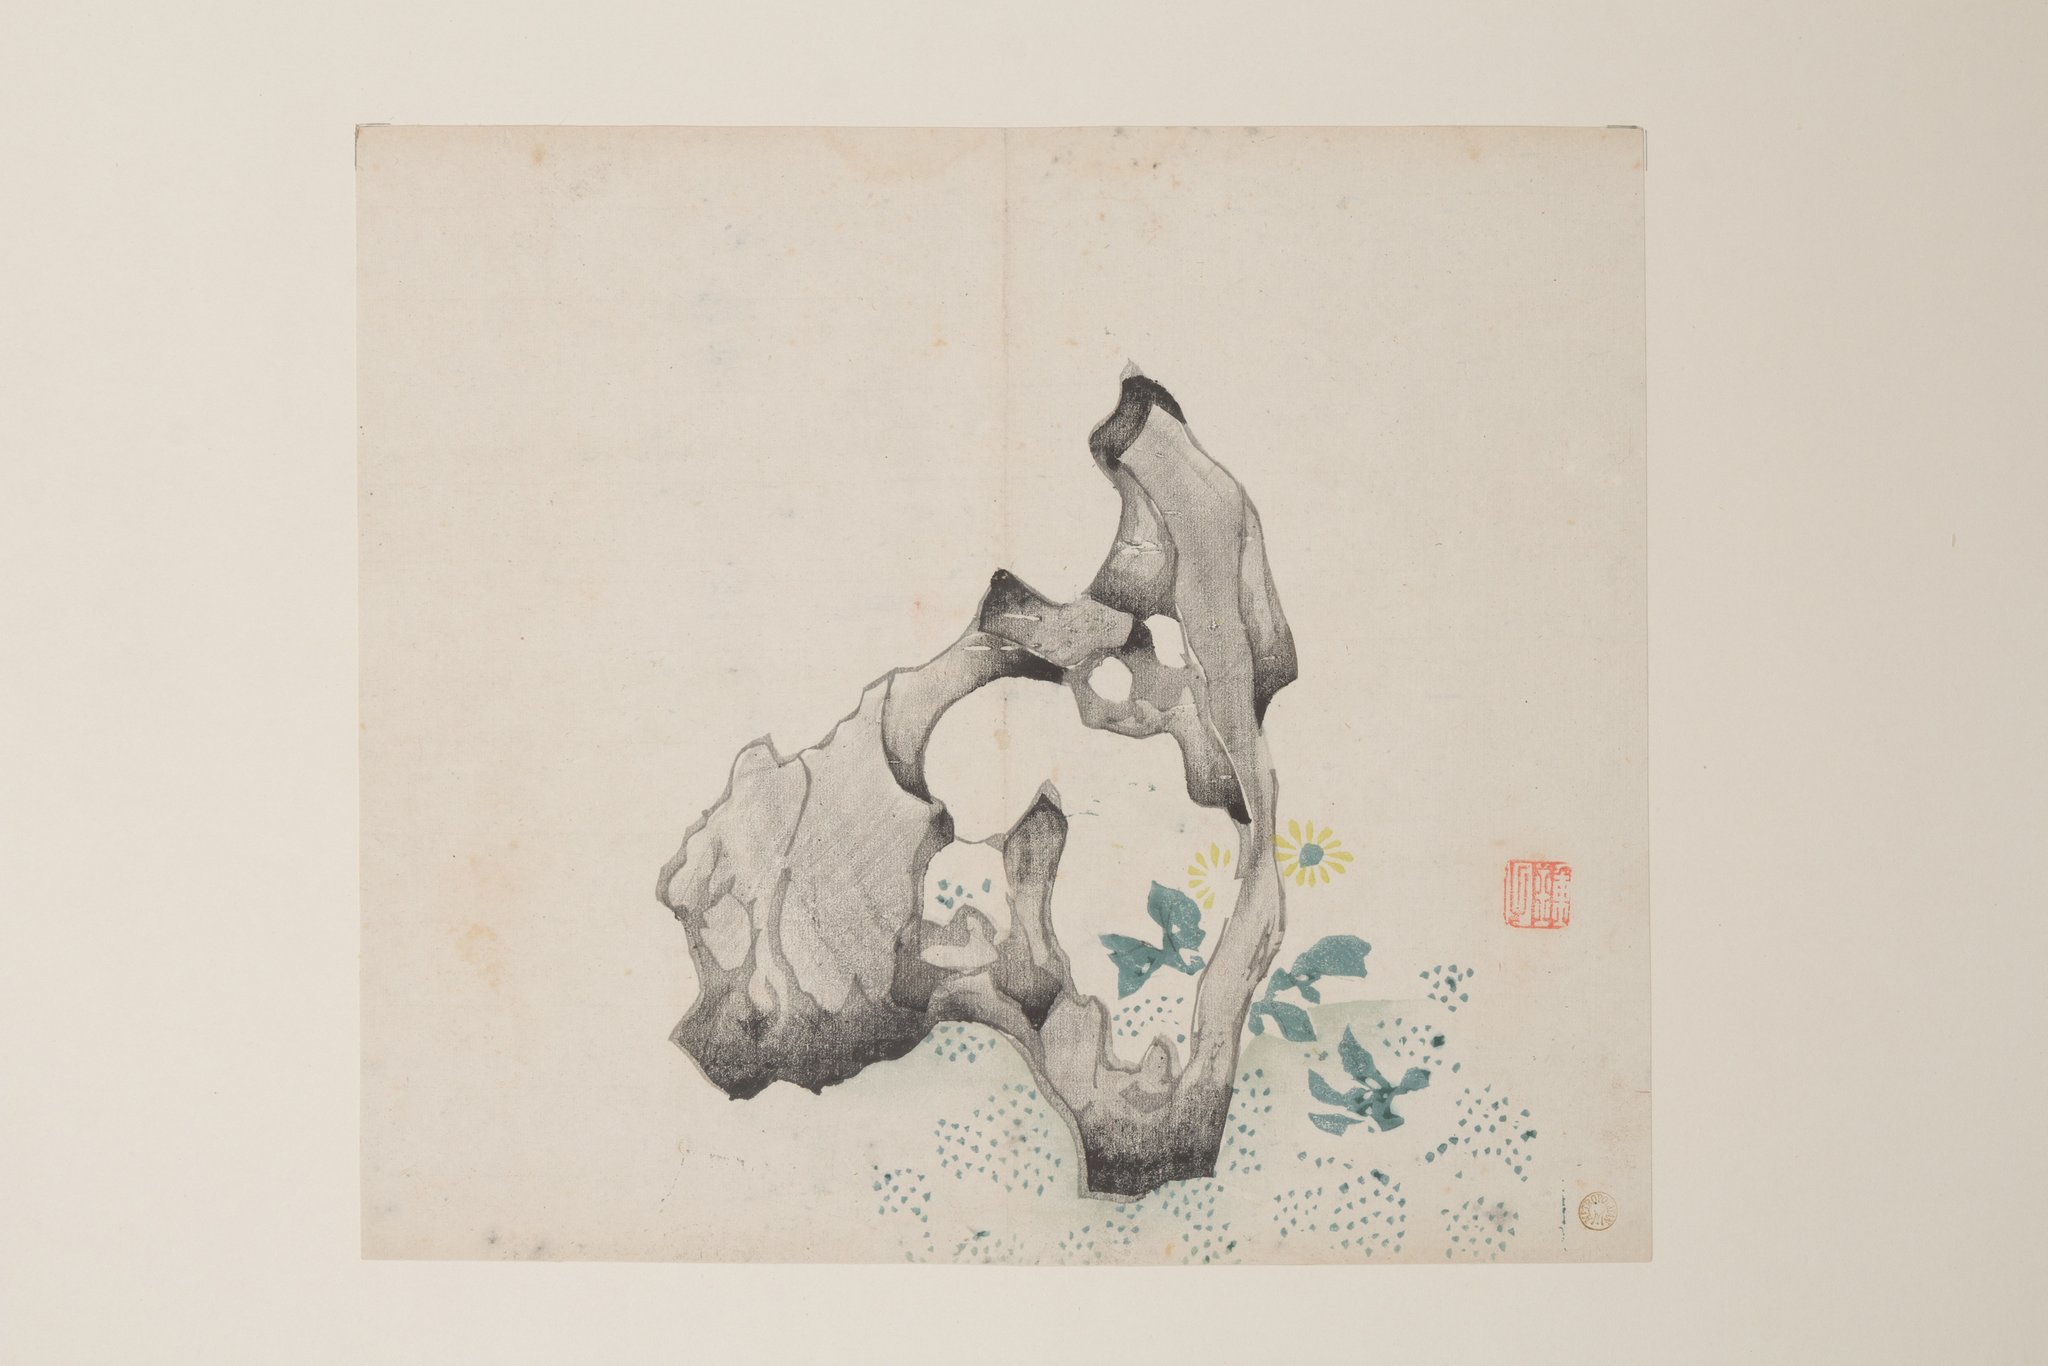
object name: print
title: Page from the Ten Bamboo Studio Manual of Painting and Calligraphy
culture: chinese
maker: hu zhengyan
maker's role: artist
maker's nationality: chinese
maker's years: 1584-1634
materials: ink, paper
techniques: printing